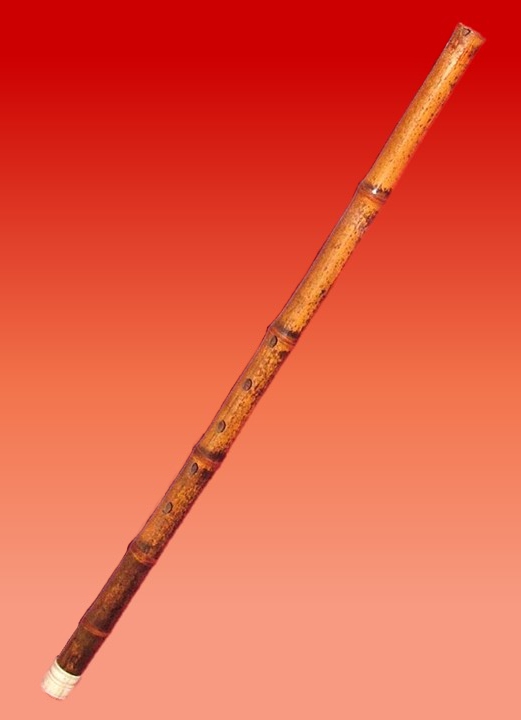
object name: xiao flute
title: Xiao (簫 )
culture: chinese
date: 1867-1900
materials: bamboo, ivory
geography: china